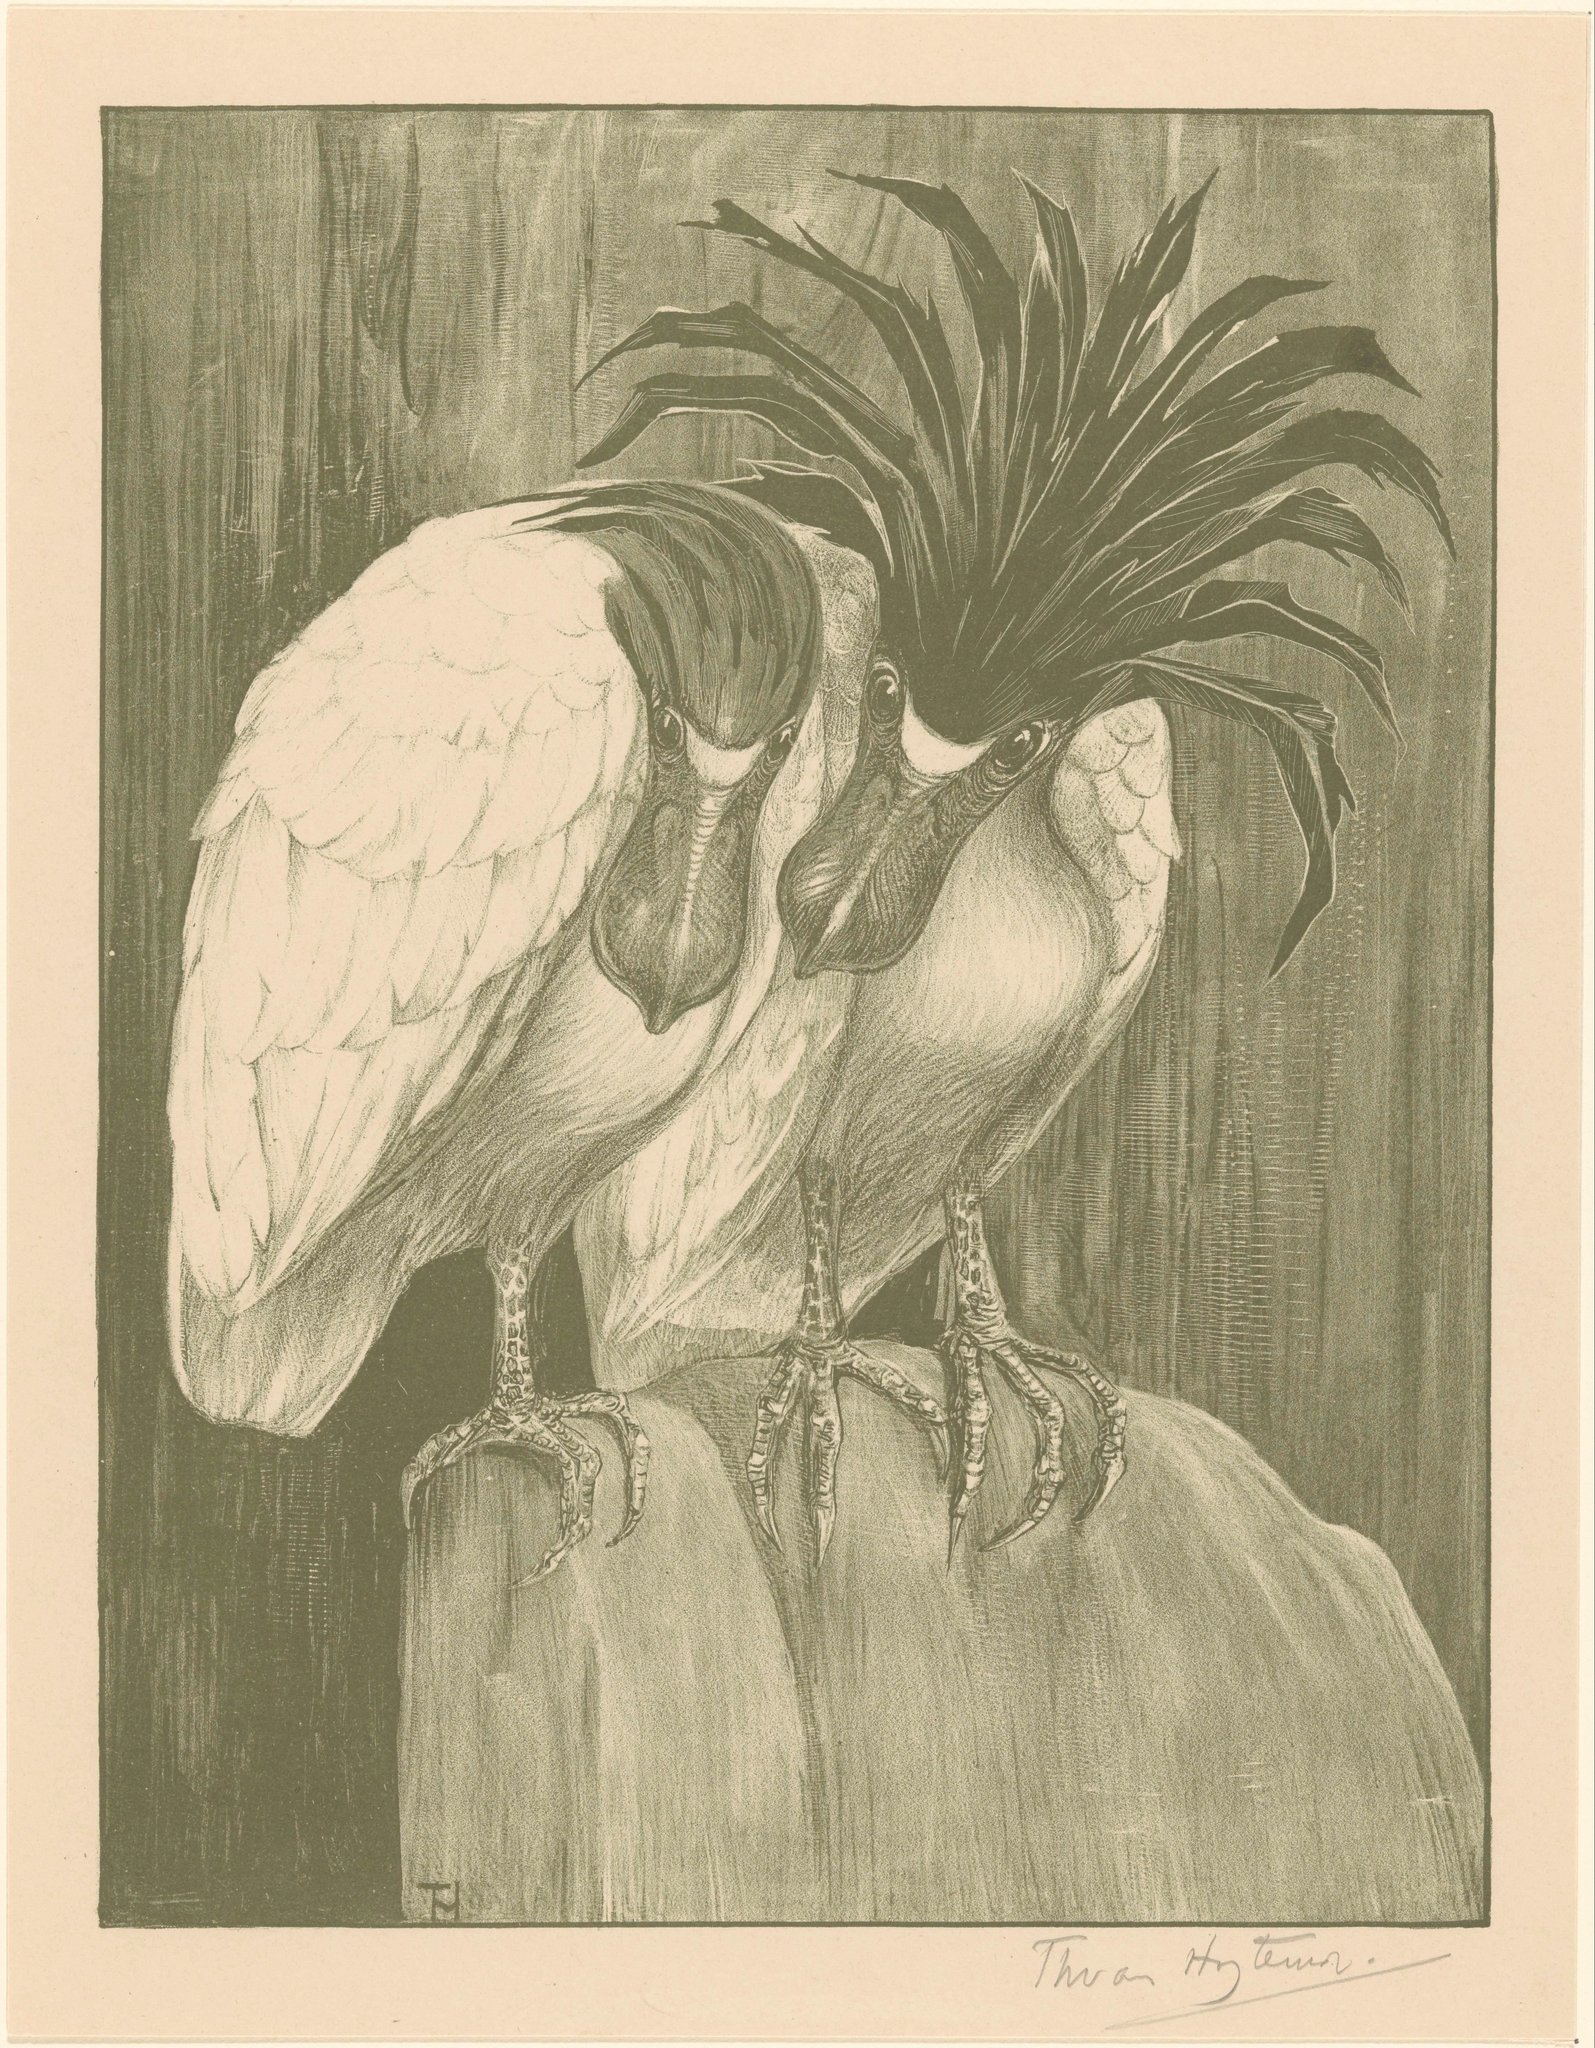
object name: print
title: Dierstudies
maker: theo van hoytema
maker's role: draughtsman, painter, print maker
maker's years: 1863-1917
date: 1878-1914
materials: paper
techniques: lithograph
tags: shore-birds and wading-birds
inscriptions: collector's mark: Lugt 2233